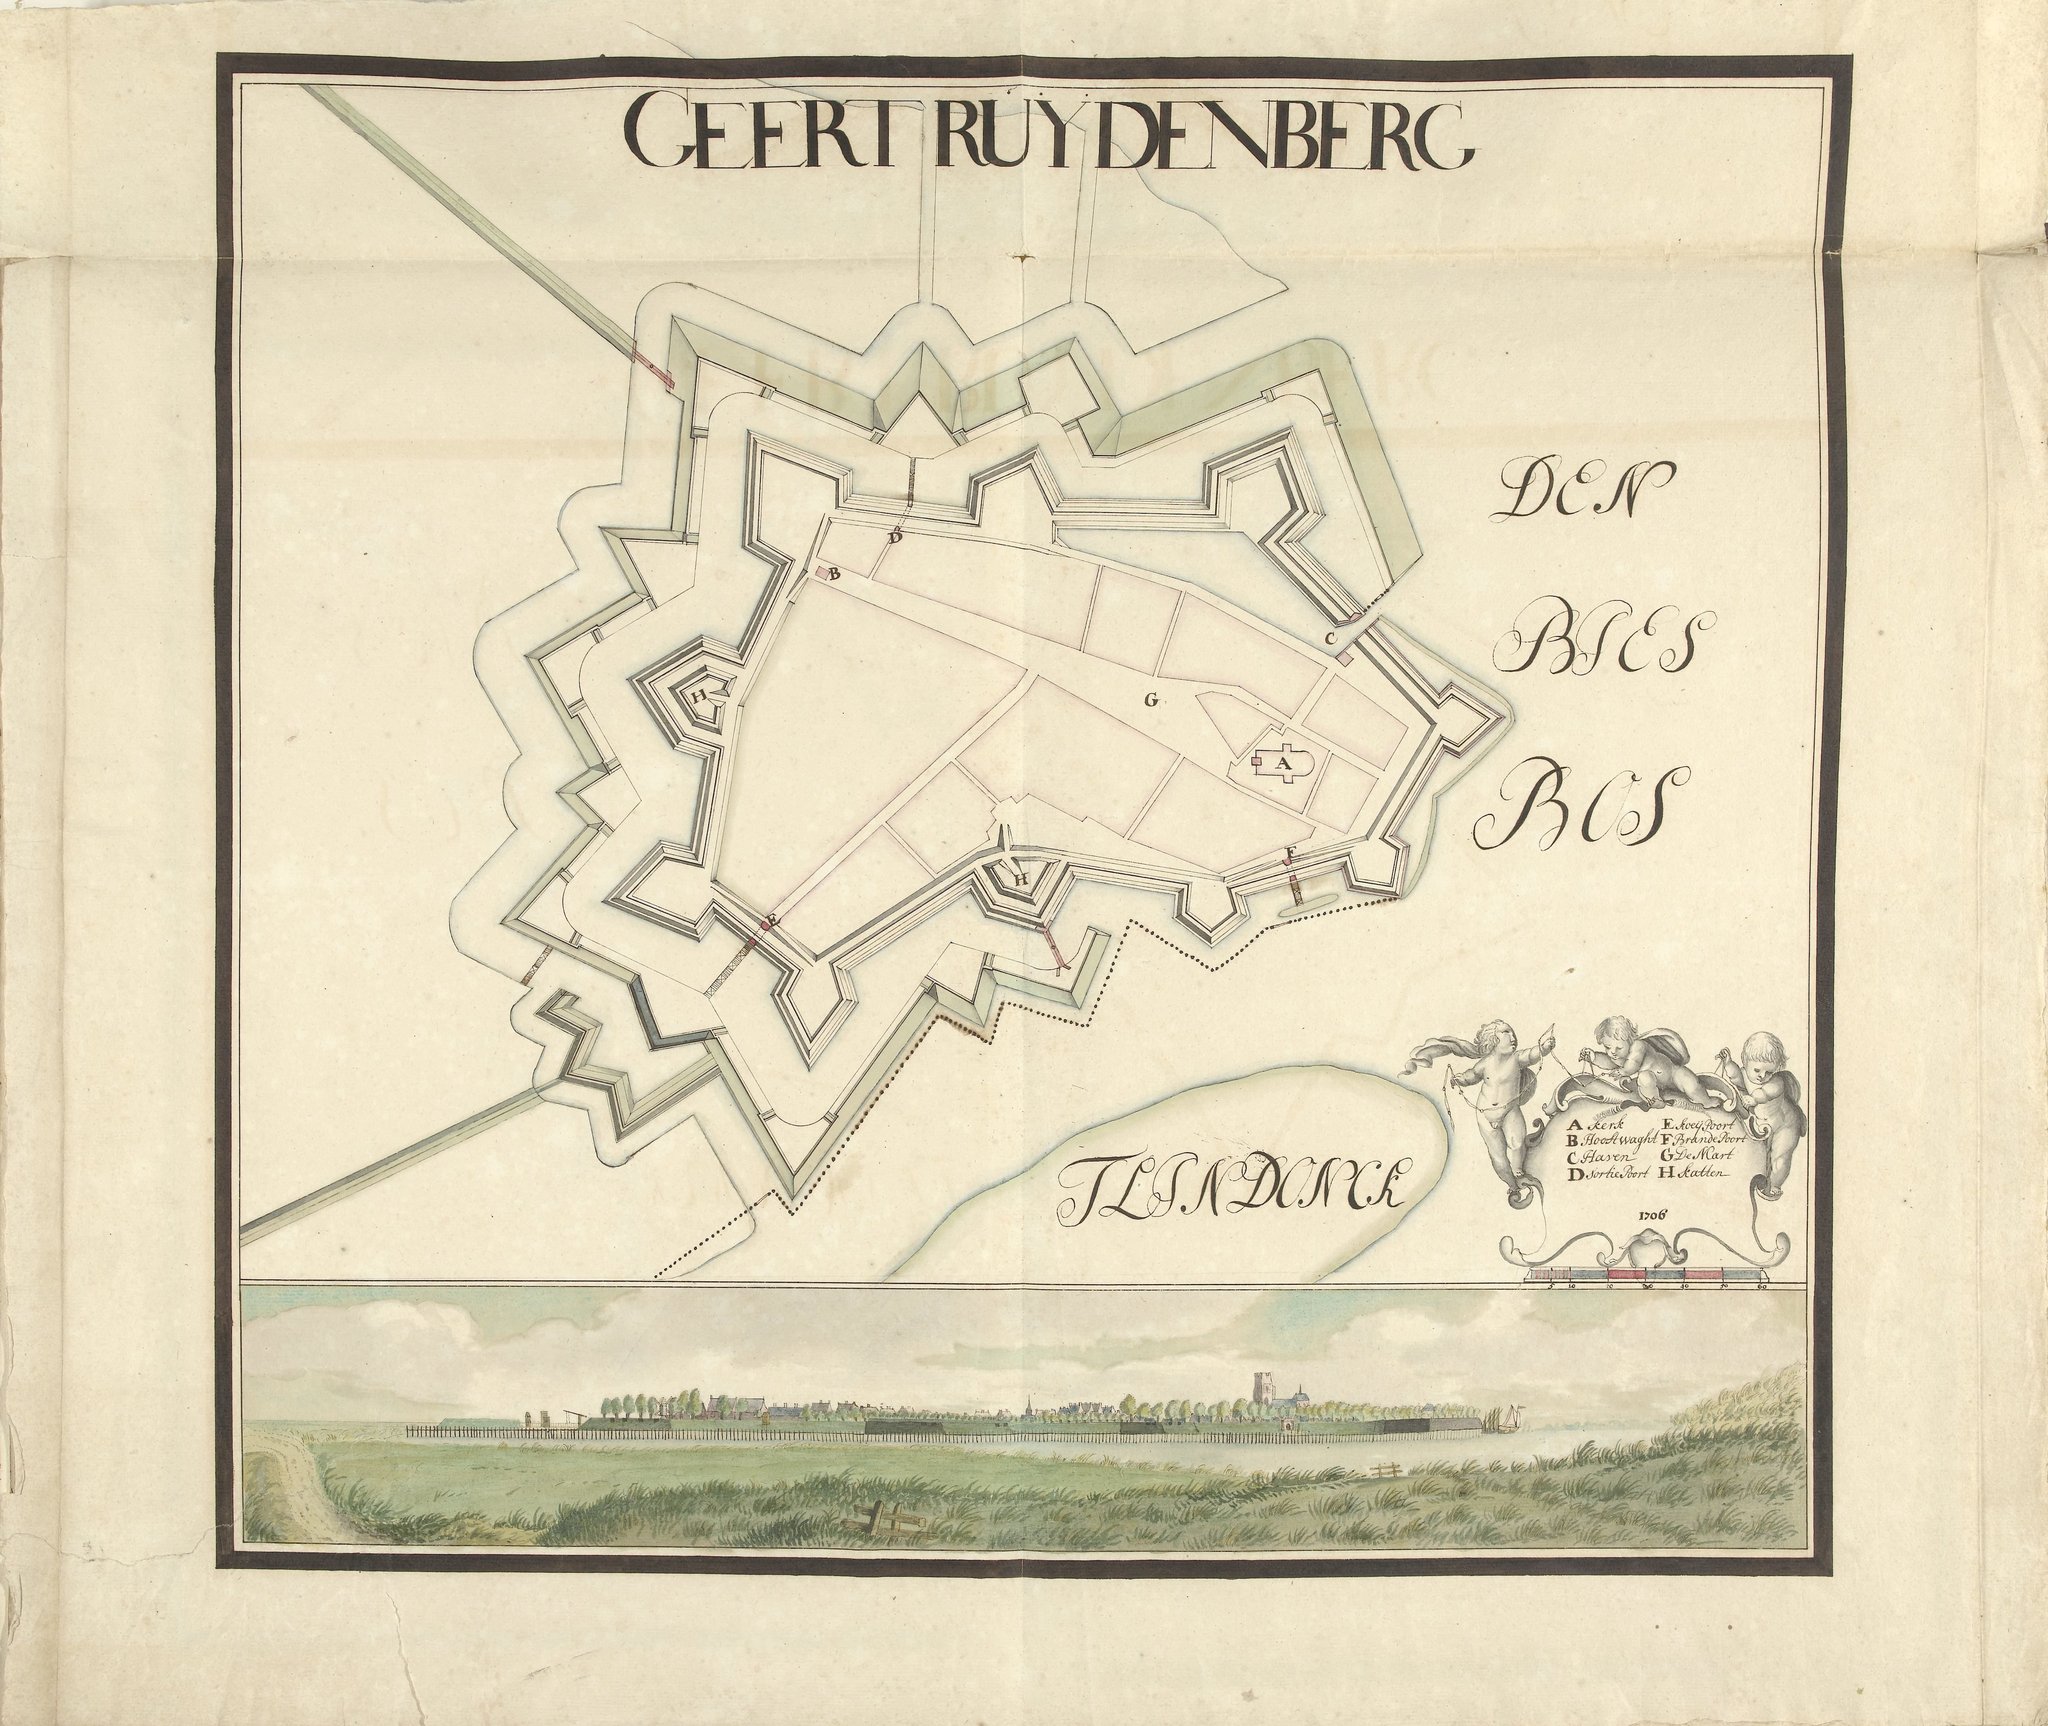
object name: map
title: Plattegrond en profiel van Geertruidenberg, 1706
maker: samuel du ry de champdoré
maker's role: draughtsman, engineer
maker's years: 1651-1729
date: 1706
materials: paper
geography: netherlands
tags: fortress, maps of cities, geertruidenberg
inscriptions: date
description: Plattegrond van de versterkingen om en een profiel van de stad Geertruidenberg, 1706. Linksonder een cartouche met de legenda A-H in het Nederlands, met vier putti met passers en meetlint. Onderdeel van een verzameling getekende plannen van versterkte plaatsen in Nederland en omringende landen ten tijde van de Spaanse Successieoorlog (deel A).